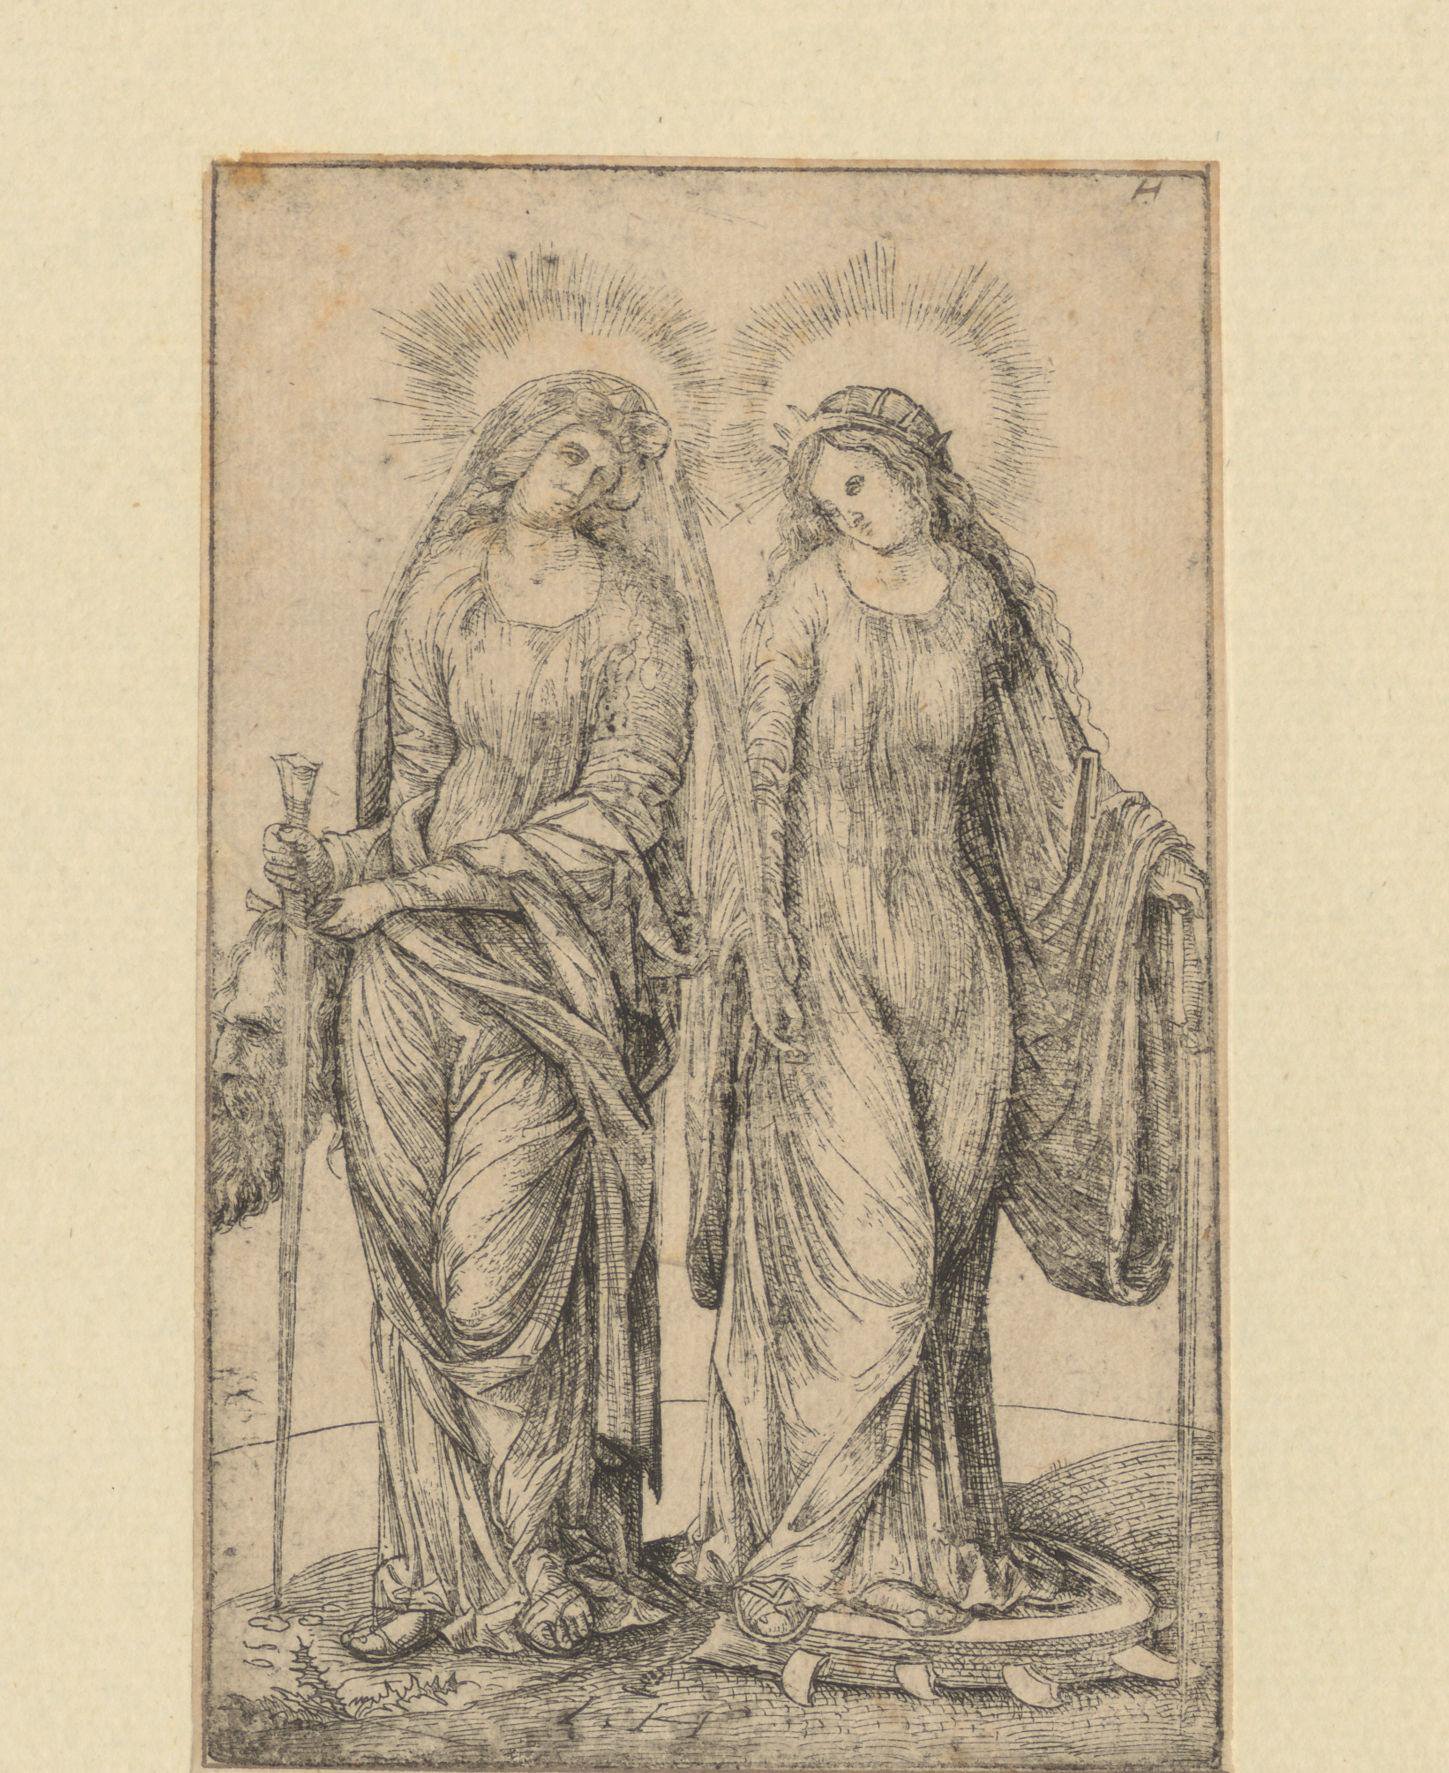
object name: print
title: Judith en H. Catharina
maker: hieronymus hopfer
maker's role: print maker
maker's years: 1500-1550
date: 1525-1550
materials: paper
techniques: etching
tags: judith with holofernes' head and the sword, male saints (with name)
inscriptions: annotation: ‘H’